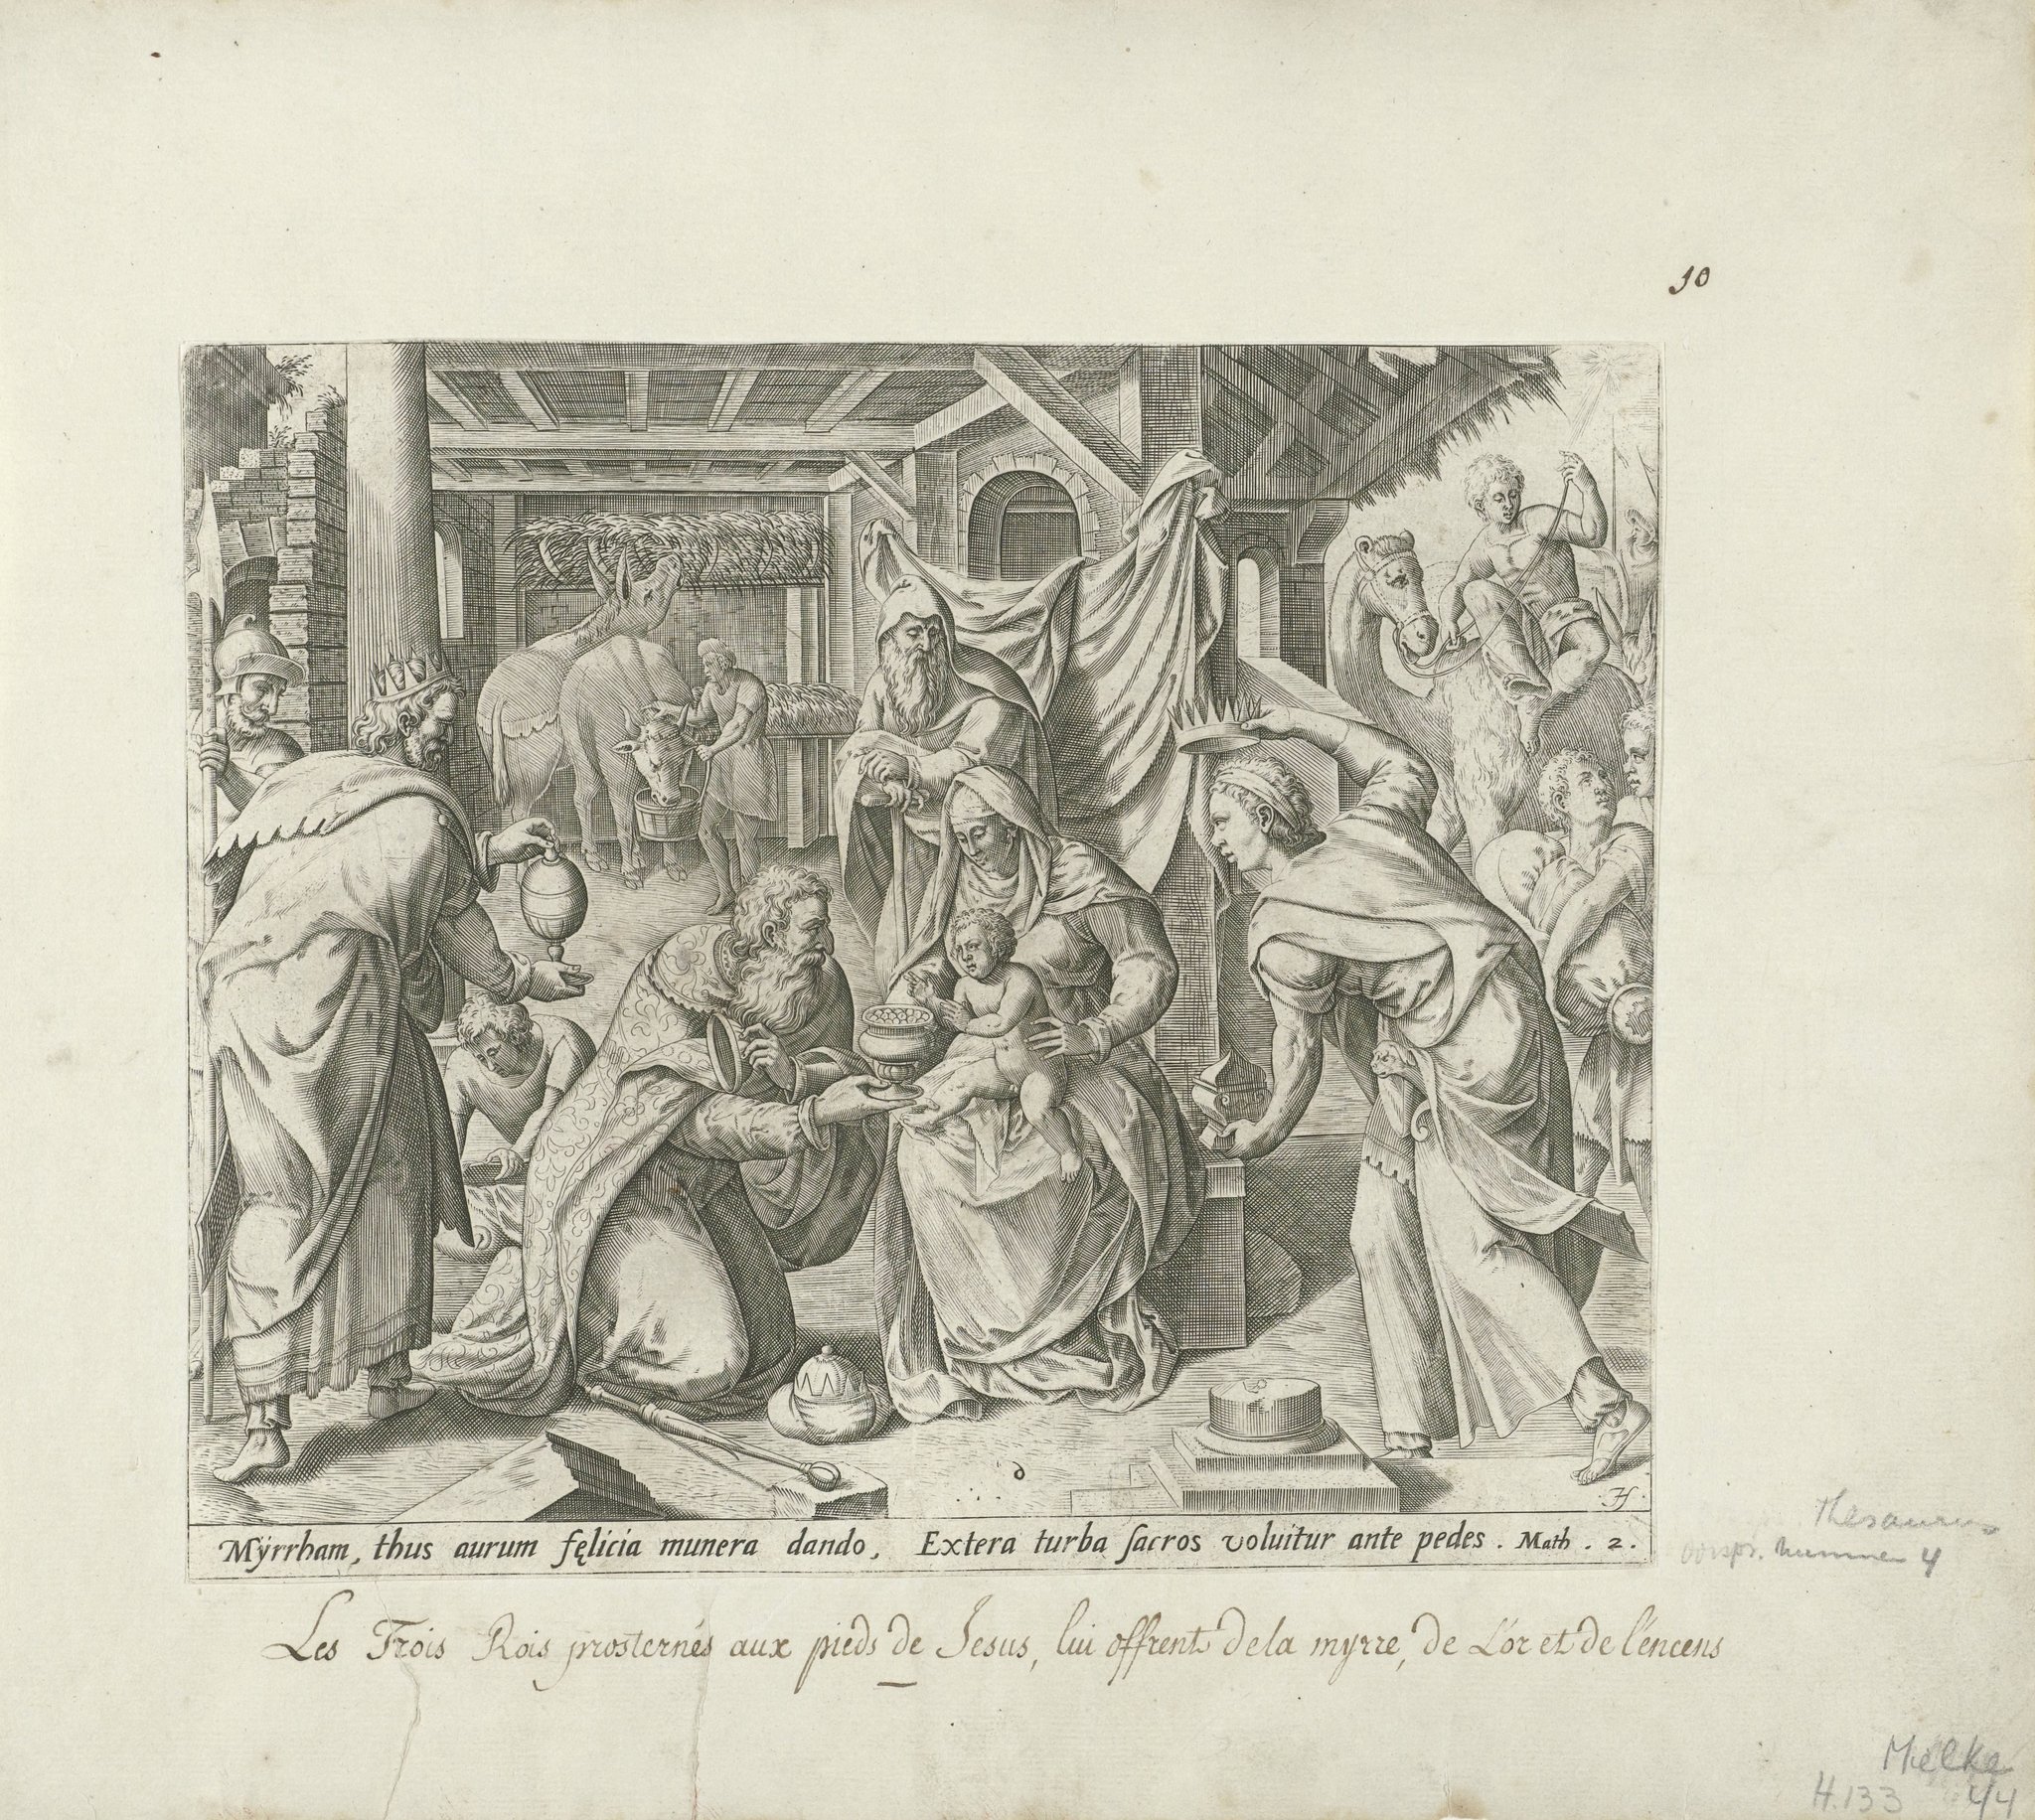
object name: print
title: Aanbidding der koningen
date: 1585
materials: paper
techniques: engraving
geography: antwerp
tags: adoration of the kings: the wise men present their gifts to the christ-child (gold, frankincense and myrrh)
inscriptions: caption: ‘Les trois Rois prosternés aux pieds de Jesus, lui offrents dela myrre de l'or et de l'encens’, number: ‘10’, collector's mark: Lugt 2228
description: De drie koningen hebben de ster gevolgd naar de stal en groeten Maria en Jozef. Caspar knielt voor het Chistuskind. Alle drie hebben geschenken bij. De prent heeft een Latijns onderschrift met een Bijbeltekst.